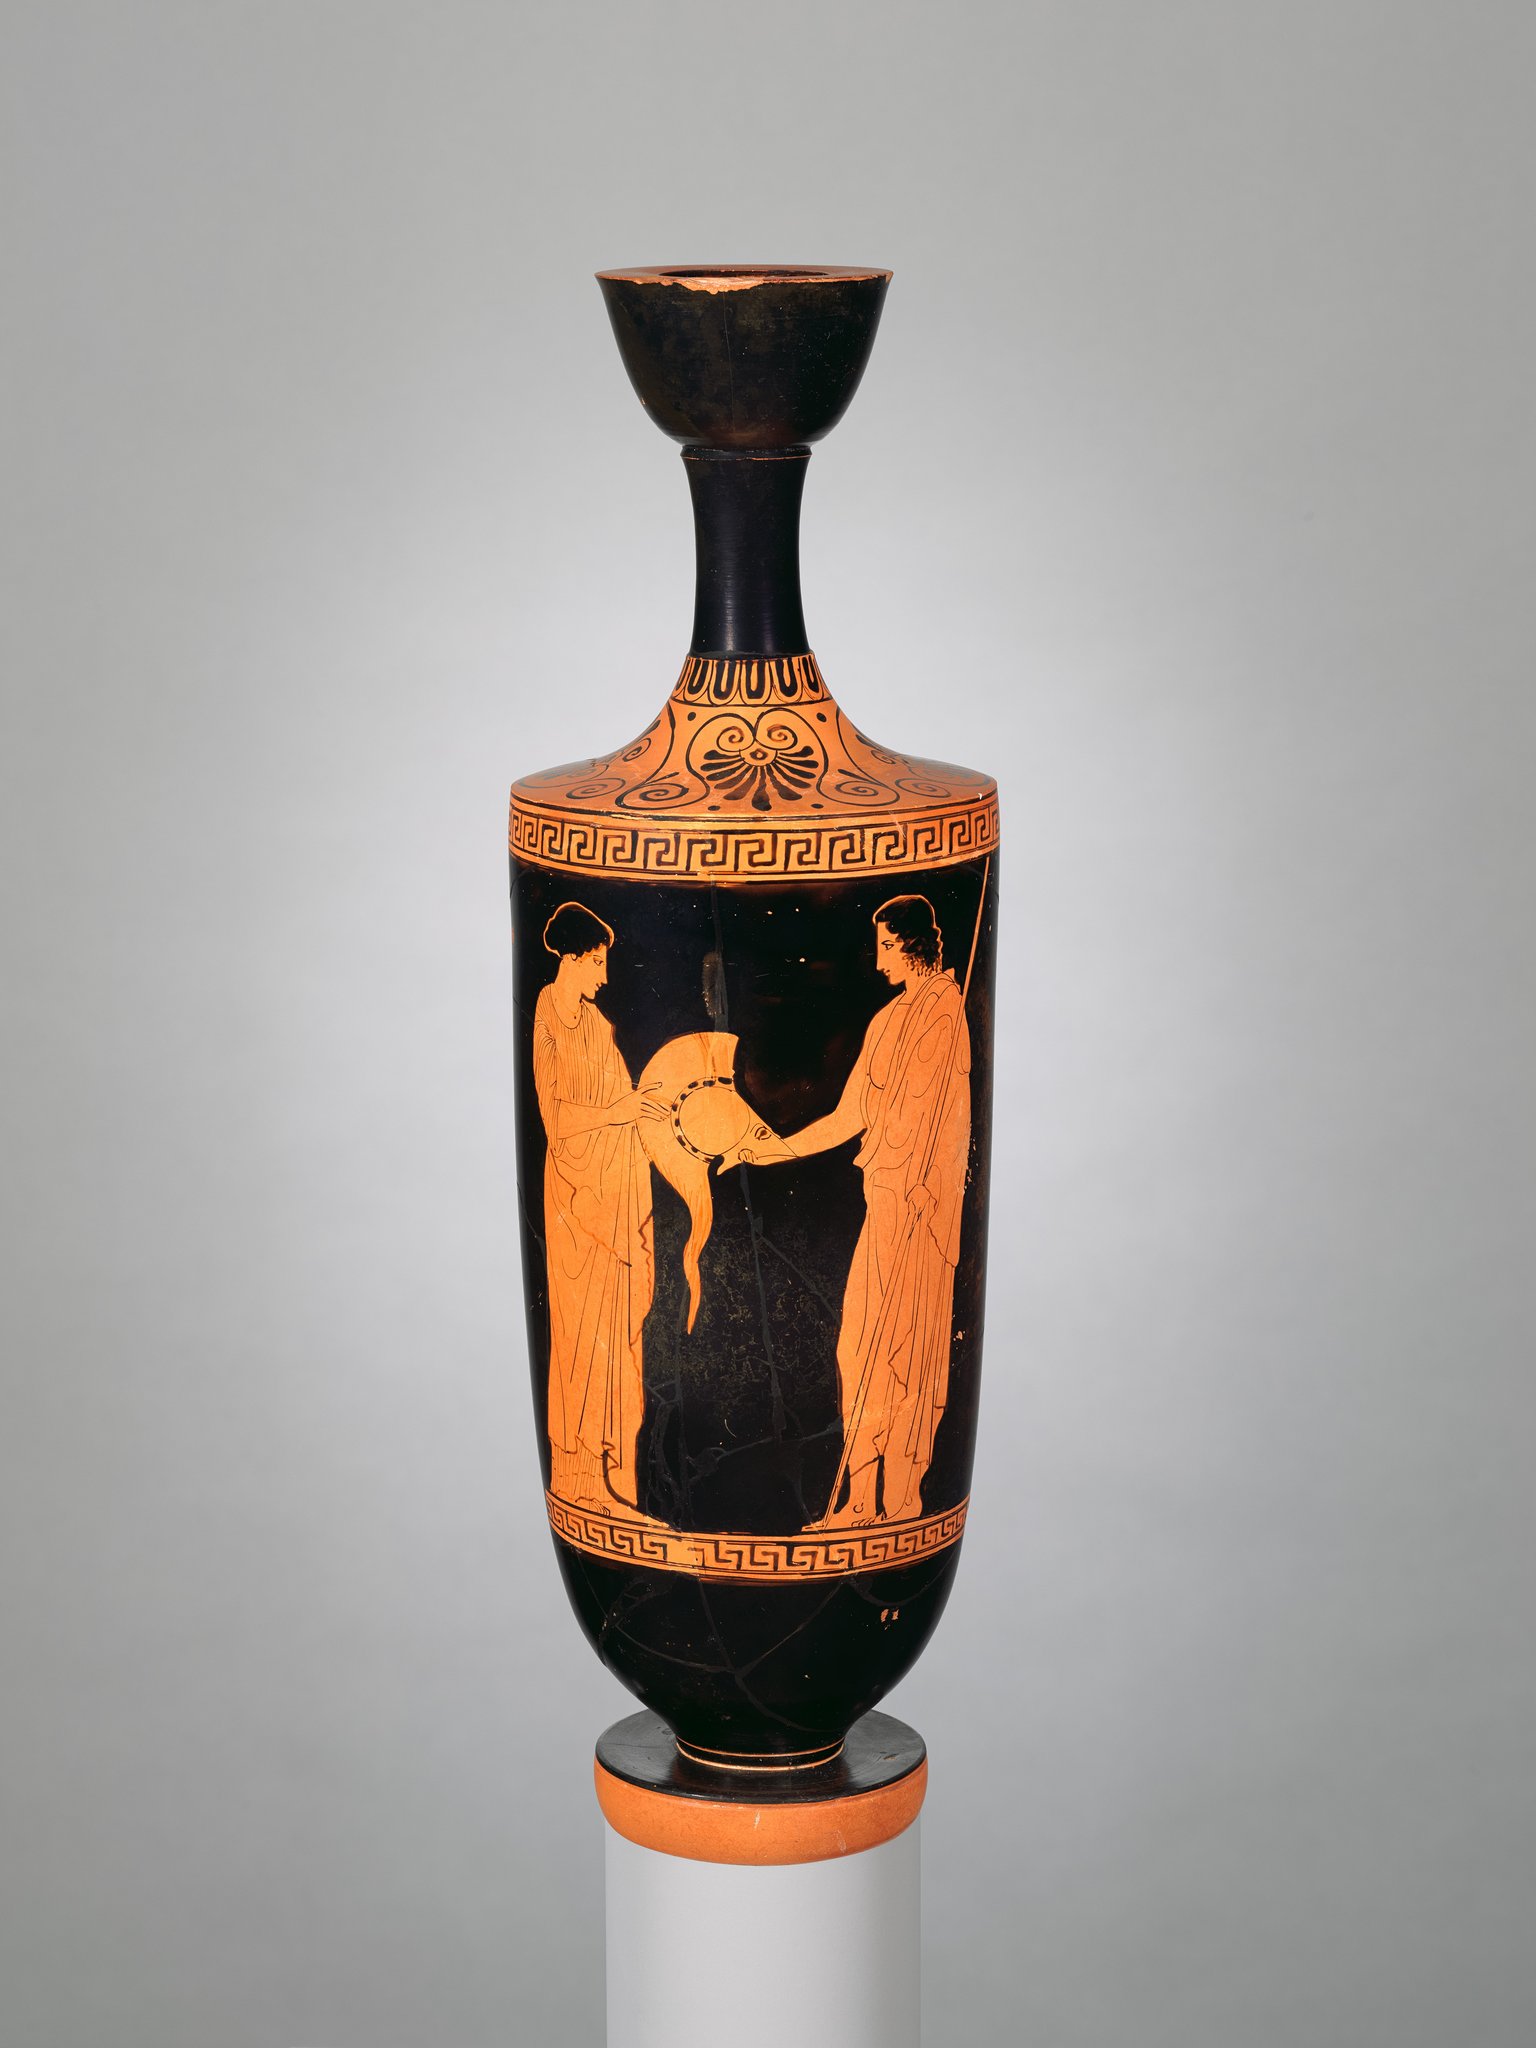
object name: lekythos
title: Terracotta lekythos (oil flask)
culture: greek, attic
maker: phiale painter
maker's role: artist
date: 440-430 BCE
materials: terracotta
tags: helmets,men,women